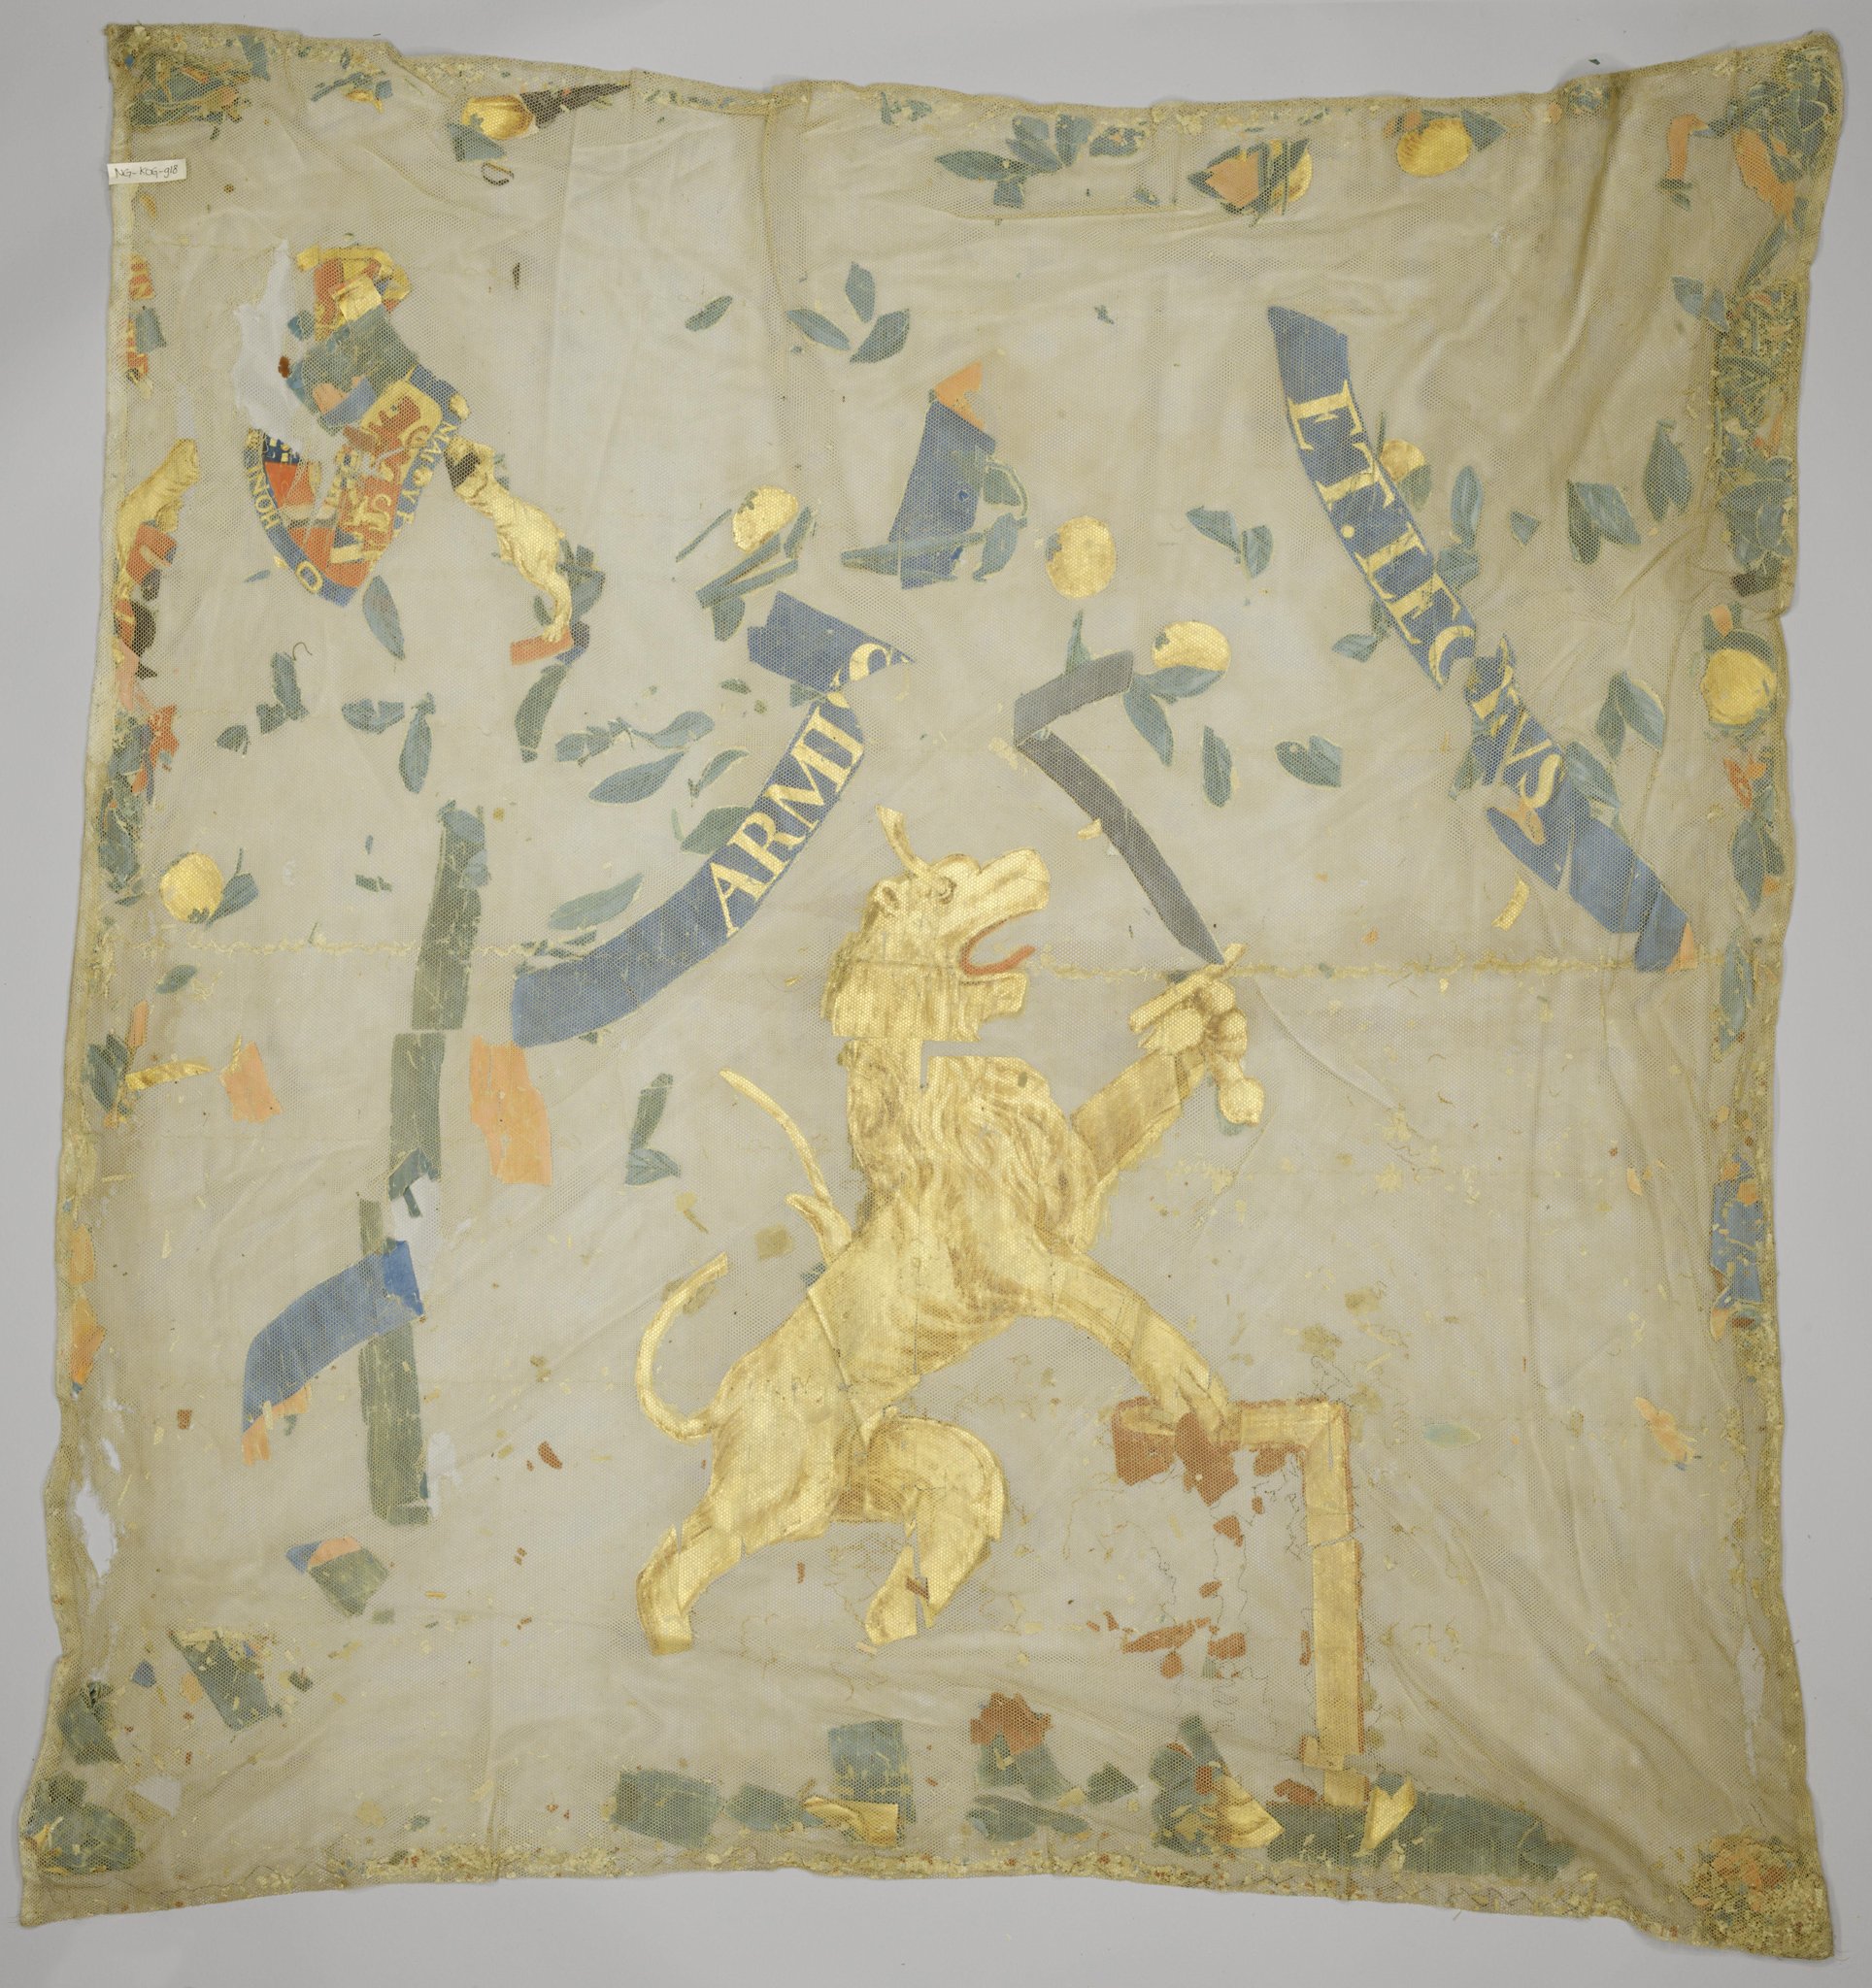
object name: banner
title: Vaandel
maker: Anonymous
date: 1762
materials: paint, silk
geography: netherlands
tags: nijmegen